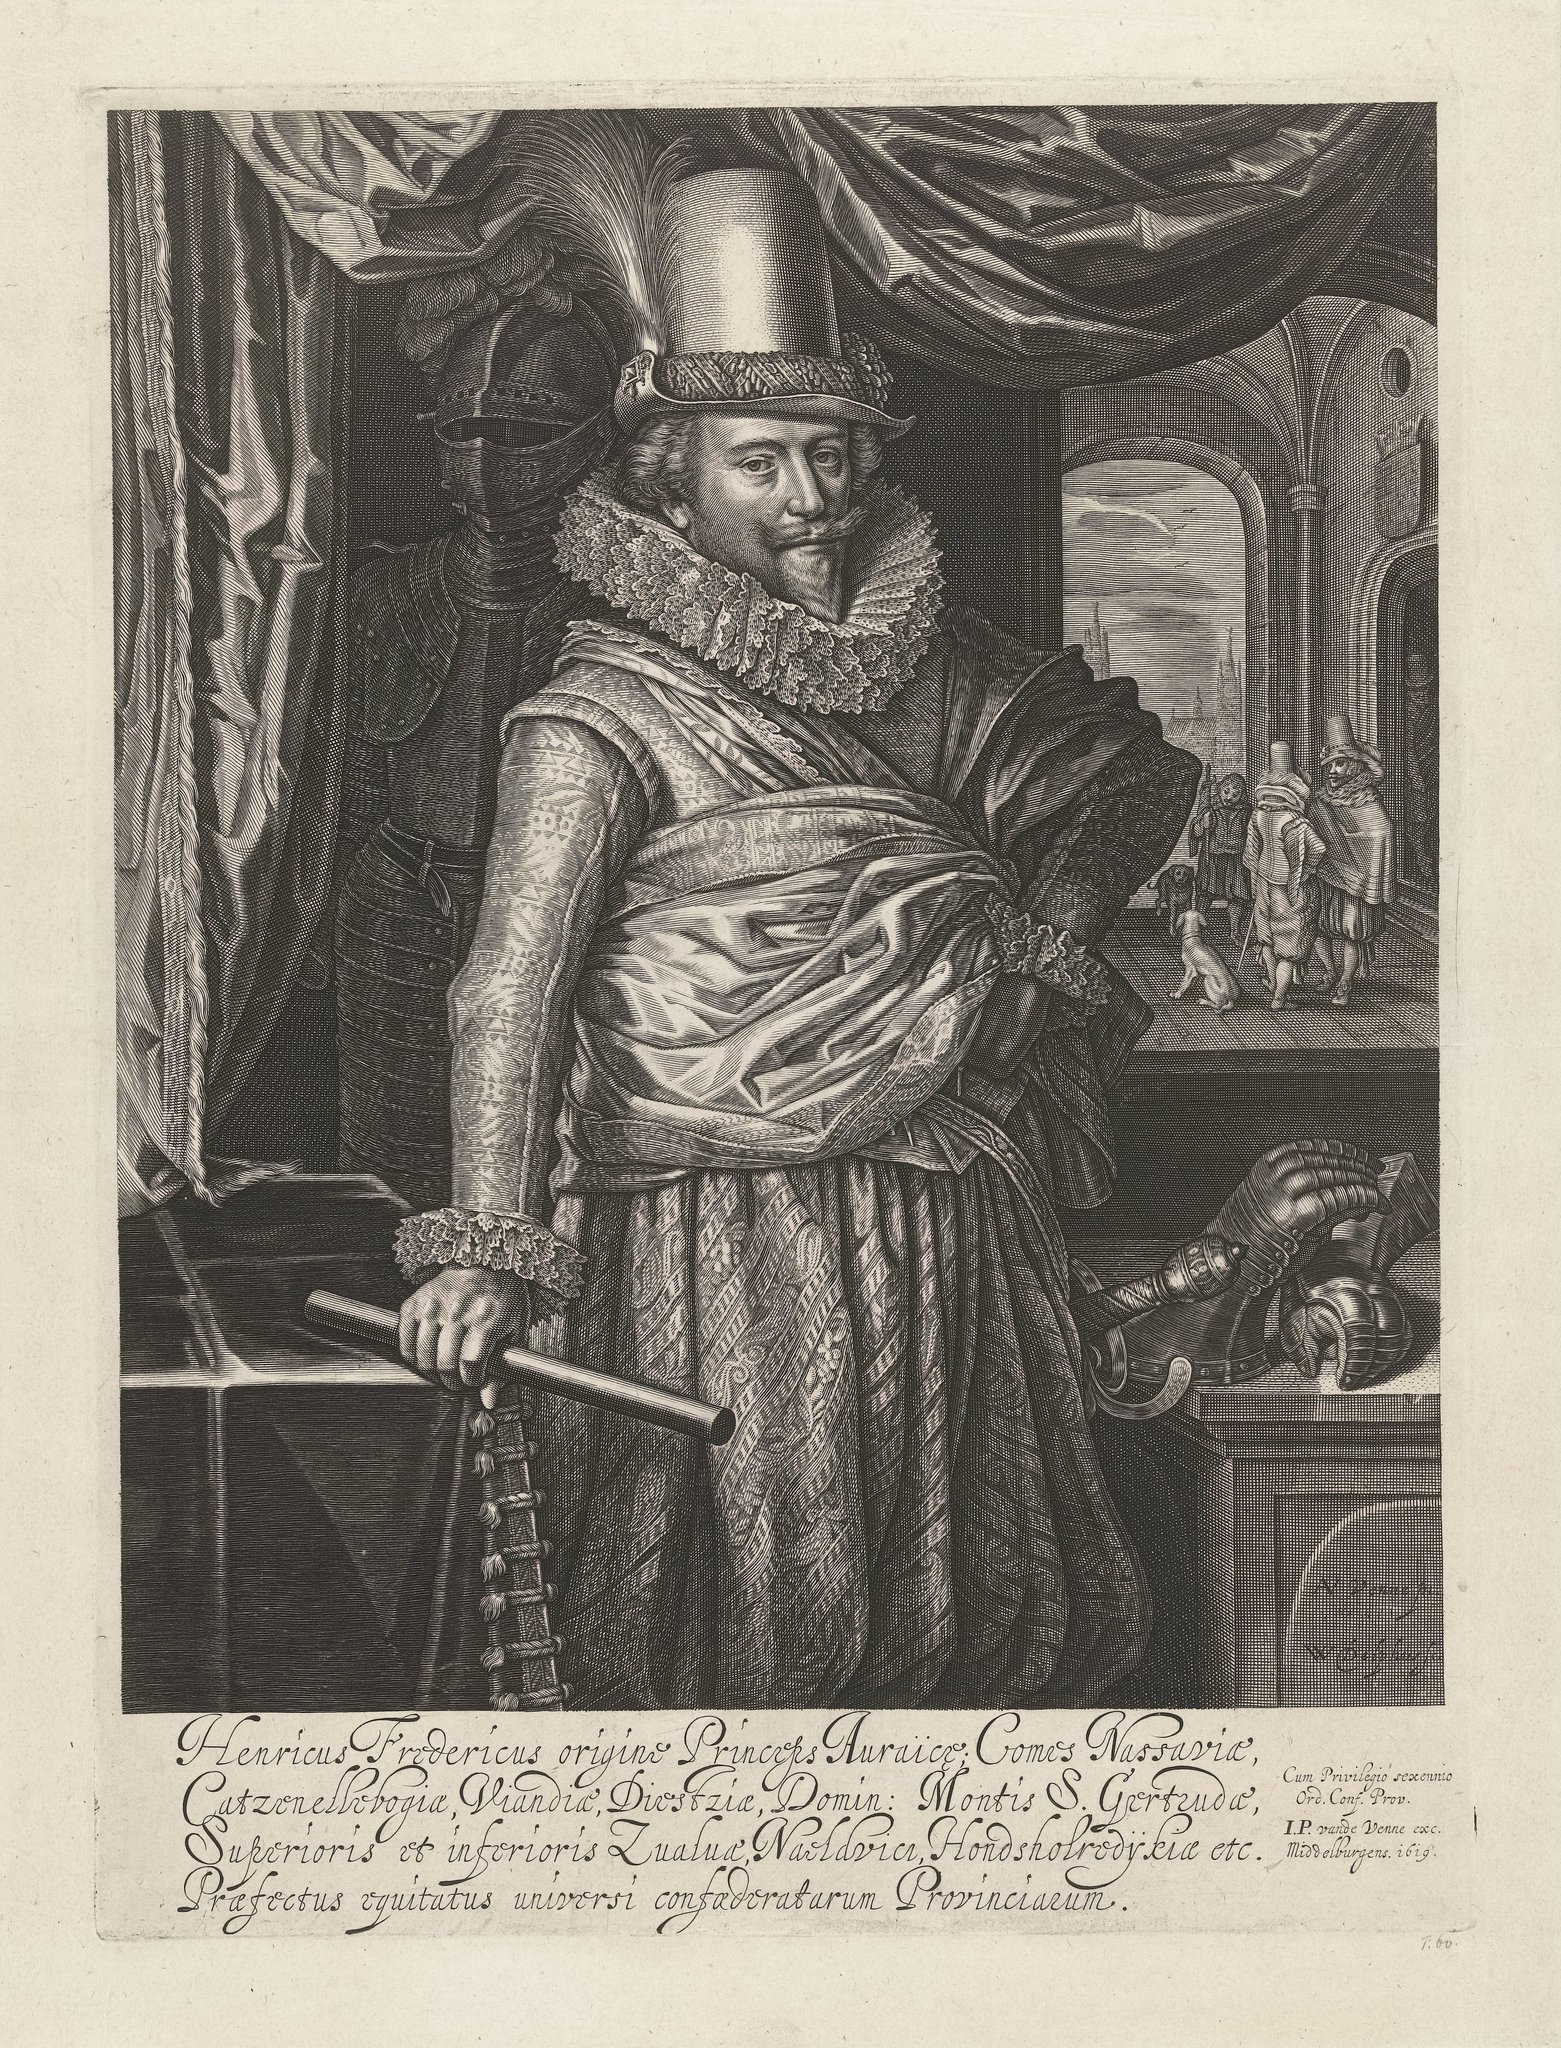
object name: print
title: Portret van Frederik Hendrik, prins van Oranje-Nassau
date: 1619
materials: paper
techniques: engraving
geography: middelburg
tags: frederick henry (prince of orange)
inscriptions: collector's mark: Lugt 2228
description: Portret van Frederik Hendrik, prins van Oranje-Nassau, kniestuk, staand voor een harnas en draperie in kleding die met ruime plooien valt, hoge hoed op zijn hoofd. Op achtergrond doorkijk, mogelijk het Haagse Hof. Latijns opschrift in vier regels.